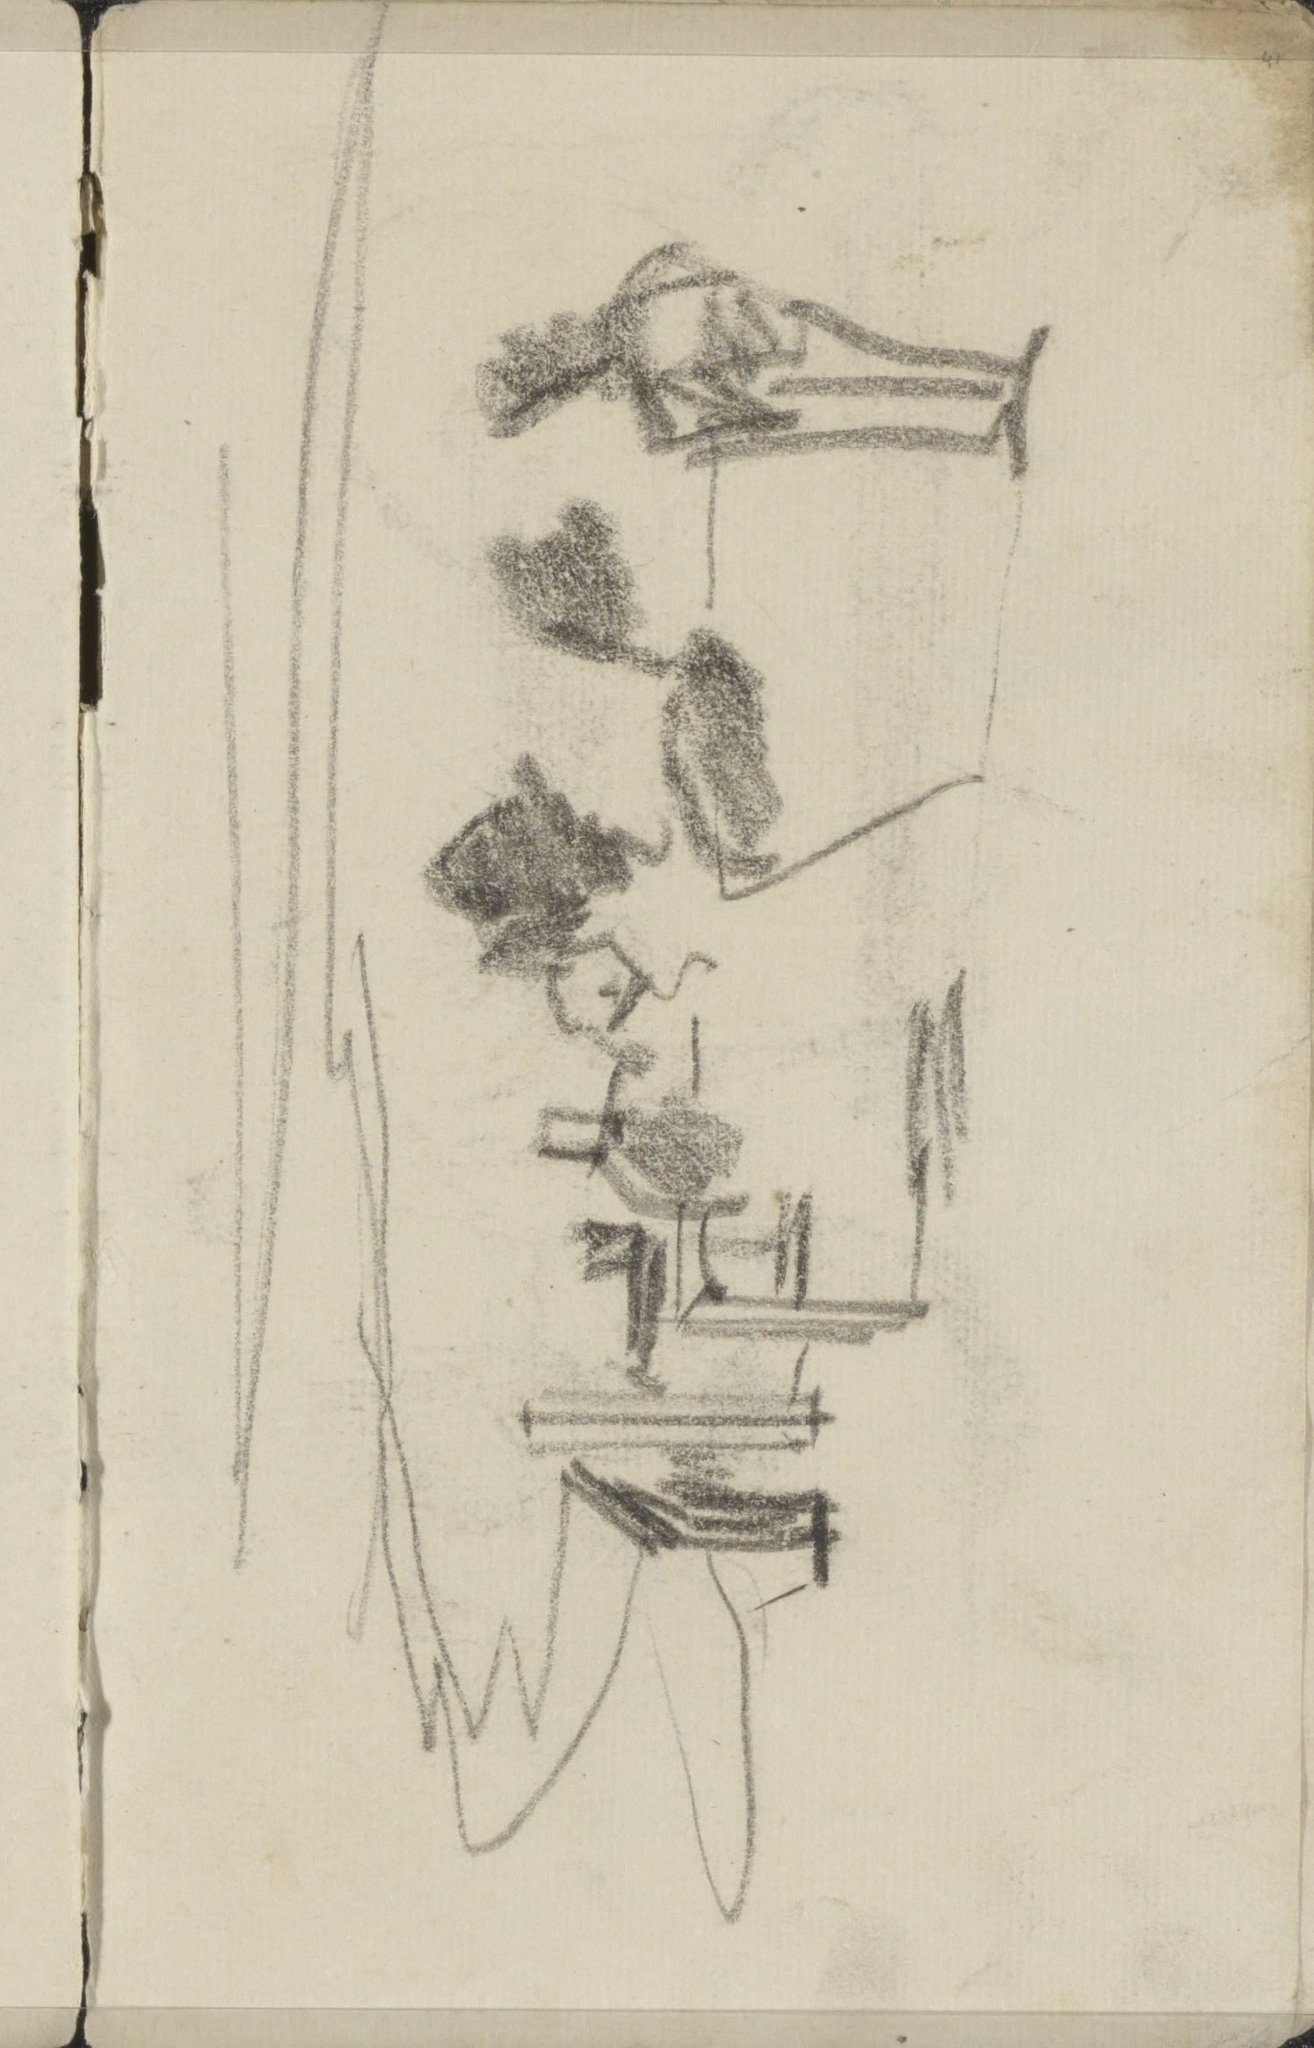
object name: sketchbook leaf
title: Landschap met figuren, mogelijk soldaten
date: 1881-1883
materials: chalk, paper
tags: landscapes, the soldier; the soldier's life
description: Pagina 41 uit een schetsboek met 29 bladen.